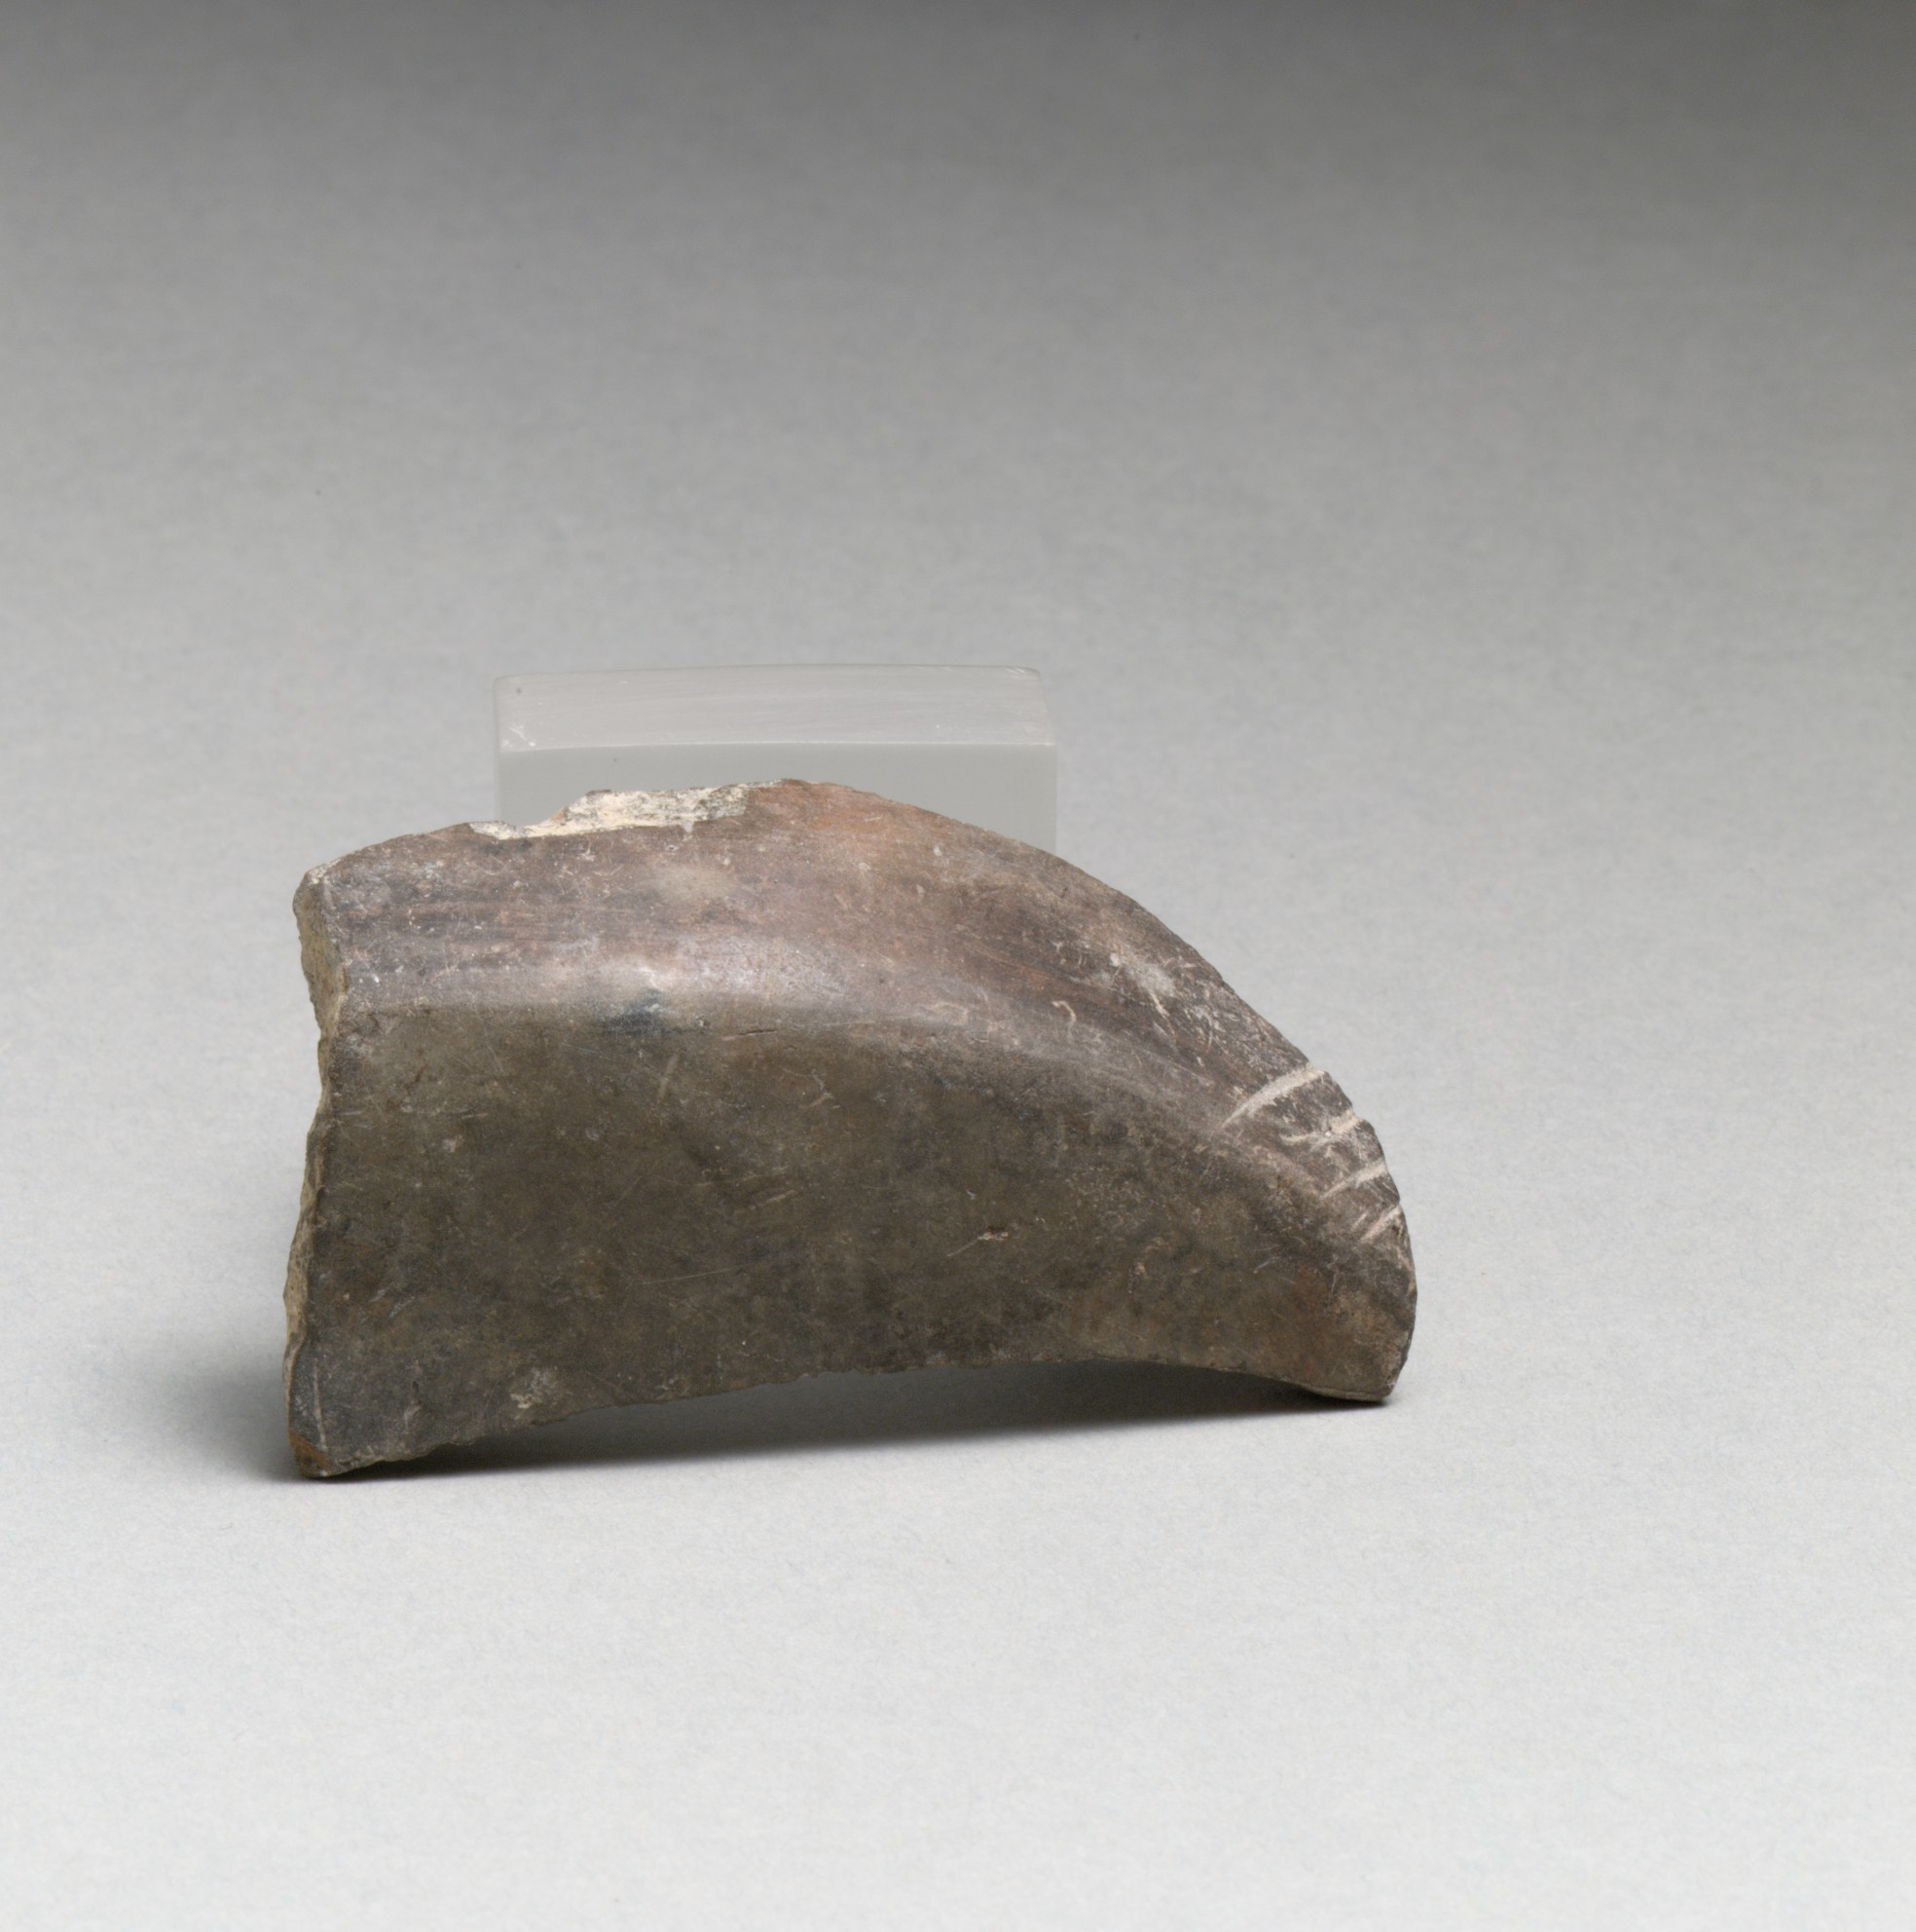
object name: vase fragment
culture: aegean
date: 7000-3000 BCE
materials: terracotta